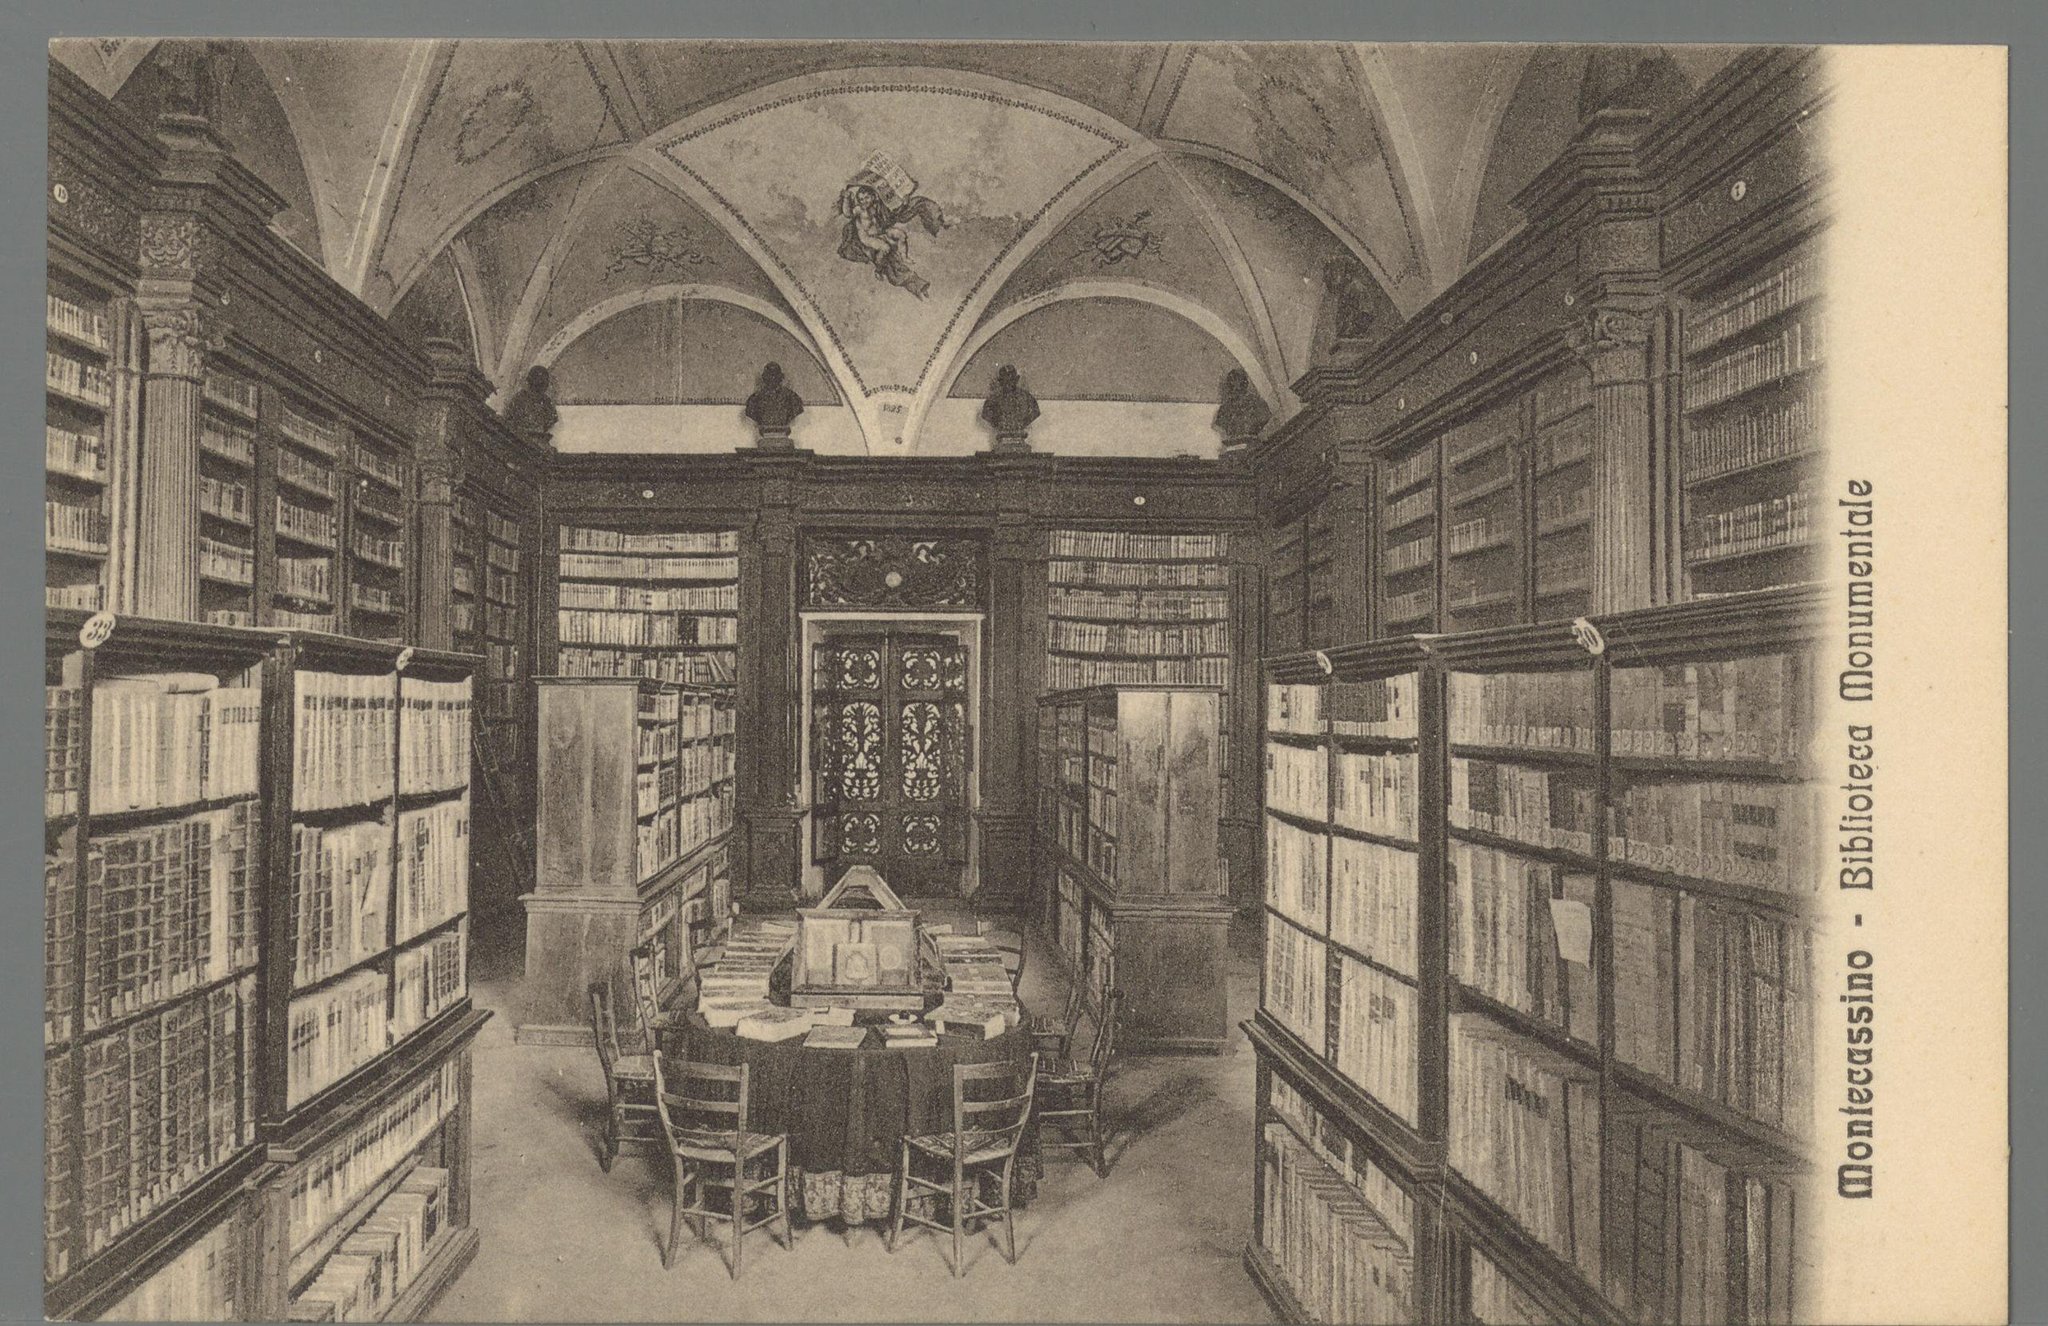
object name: photomechanical print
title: Montecassino. Biblioteca Monumentale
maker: Anonymous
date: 1906-1910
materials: cardboard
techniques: photograph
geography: cassino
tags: abbey, monastery, convent ~ roman catholic church, study; 'studiolo'; library